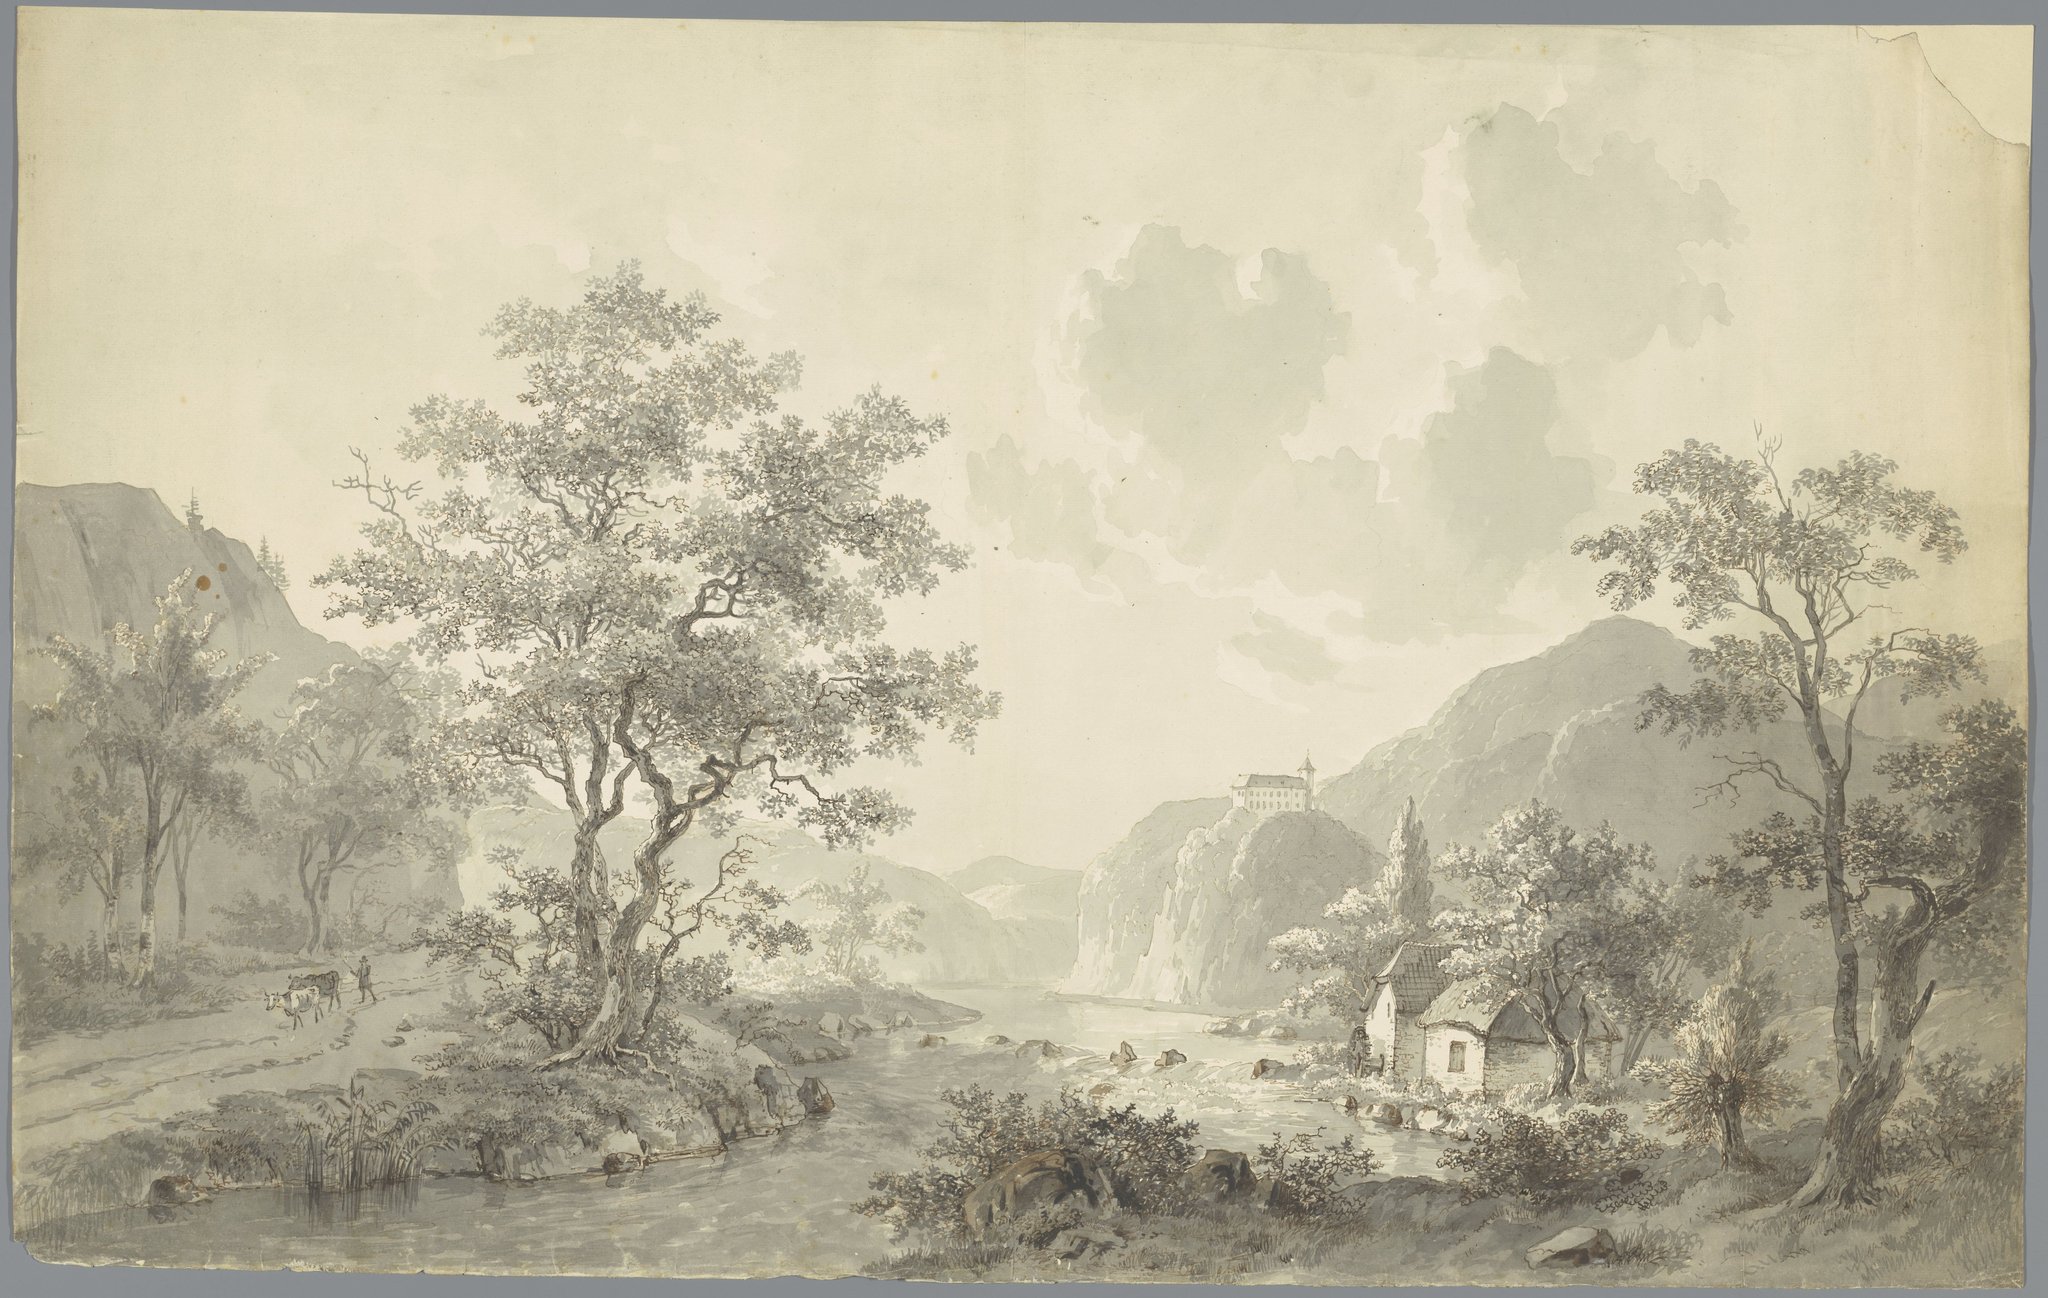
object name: drawing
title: Watervalletje bij een meer in een berglandschap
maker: jacob van strij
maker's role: draughtsman, painter, print maker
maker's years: 1756-1815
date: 1766-1815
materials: ink, paper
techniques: brush, pen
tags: river, mountains